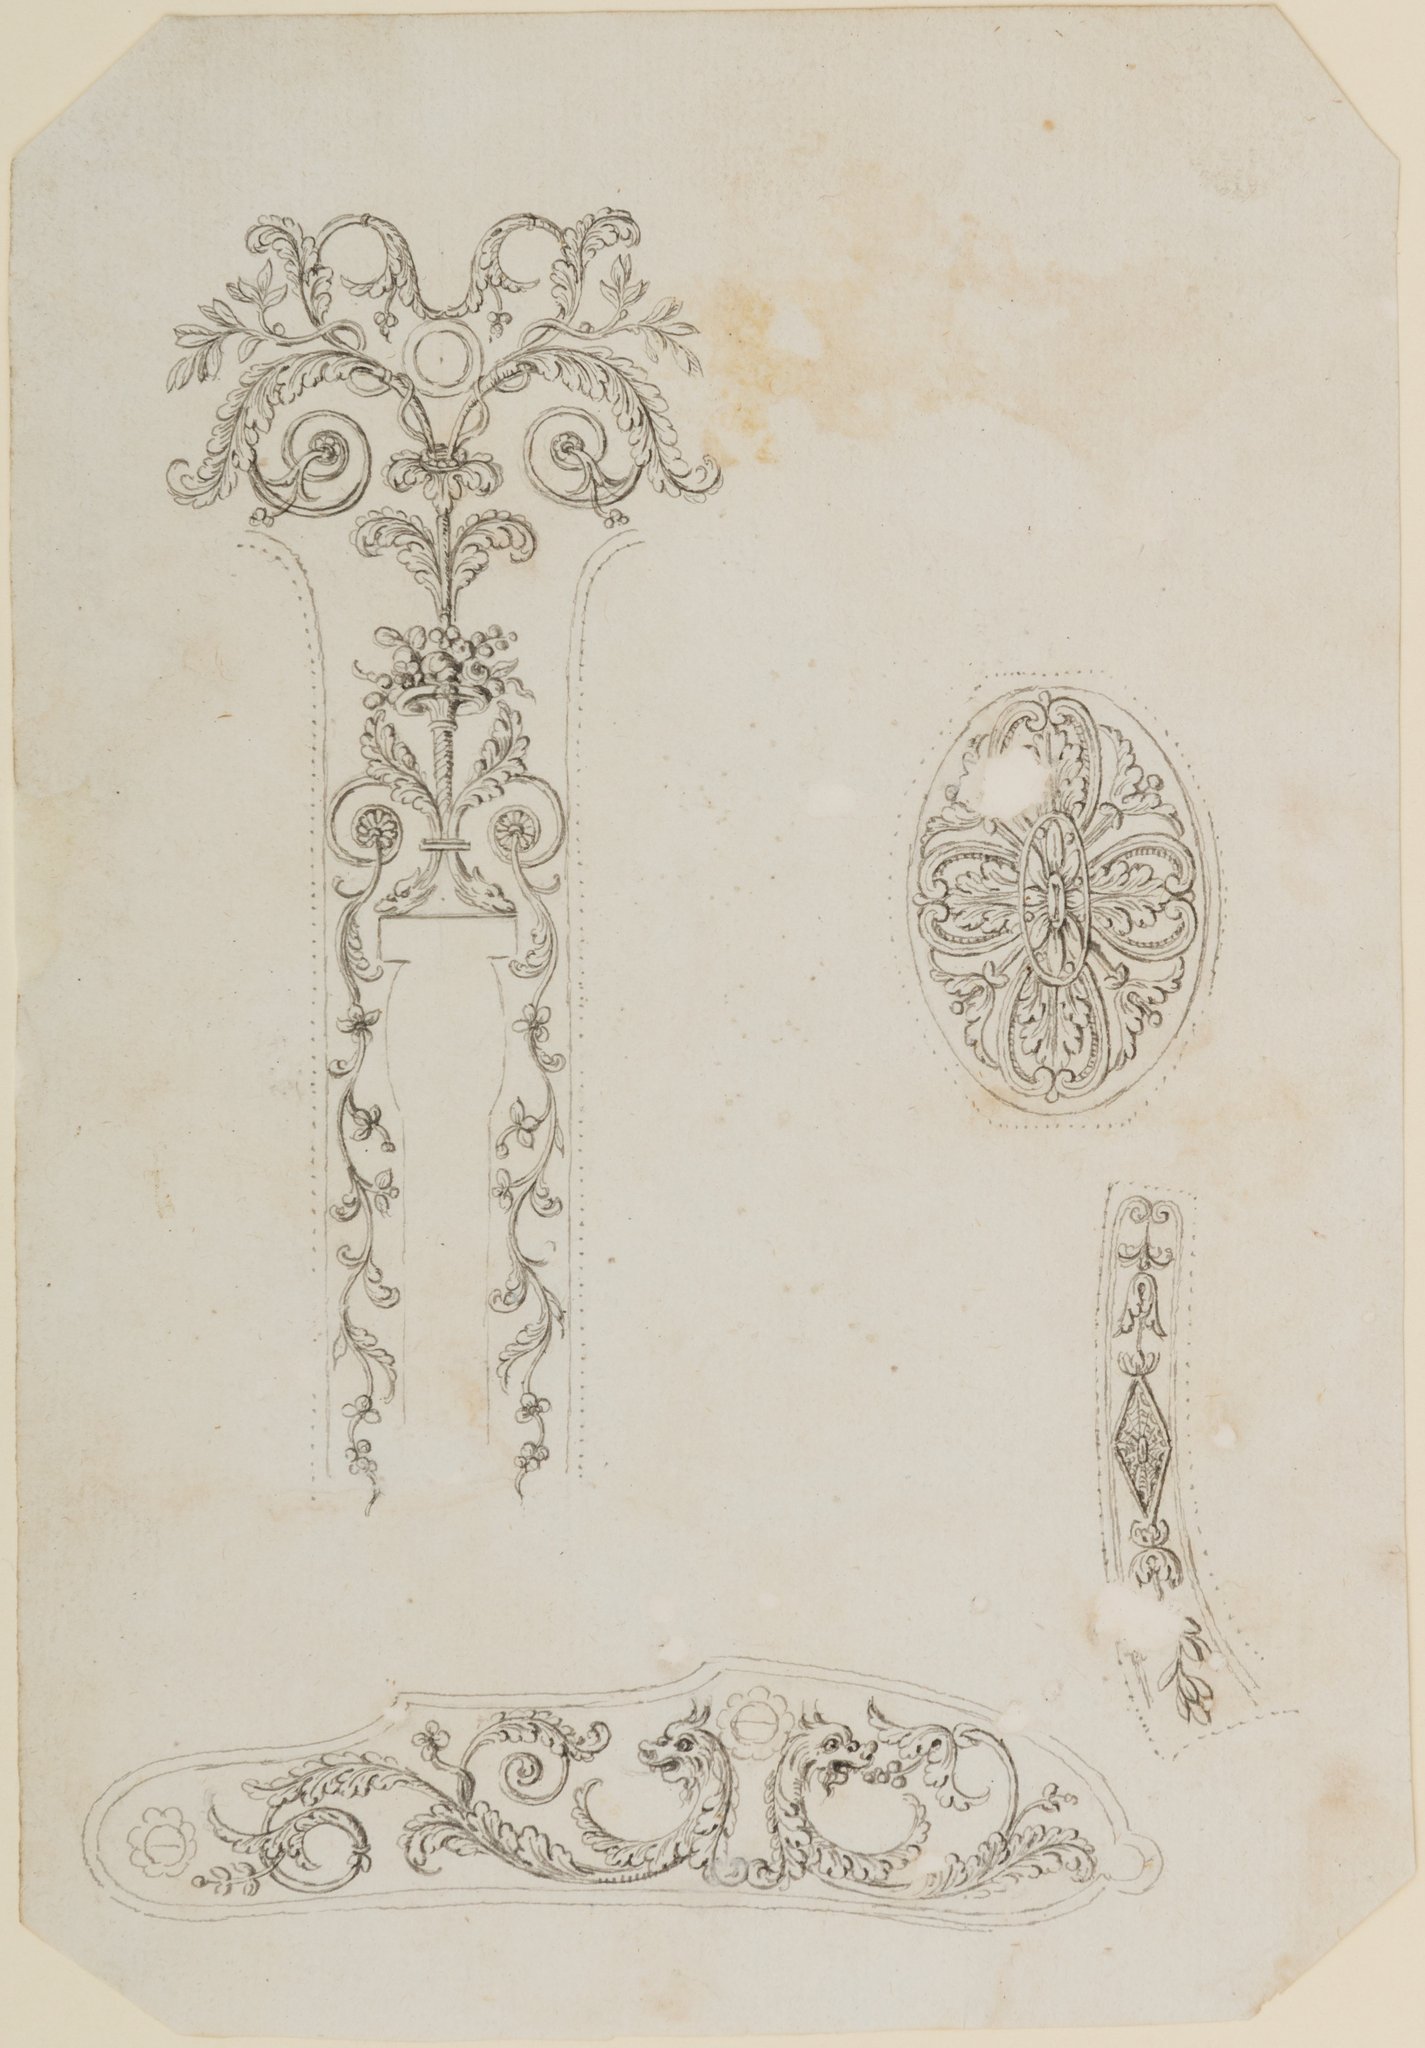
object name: drawing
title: Four Designs for the Decoration of Firearms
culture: french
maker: nicolas noël boutet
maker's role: designer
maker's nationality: french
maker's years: 1761-1833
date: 1797-1805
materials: ink, paper, pencil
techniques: wash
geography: france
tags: ornament